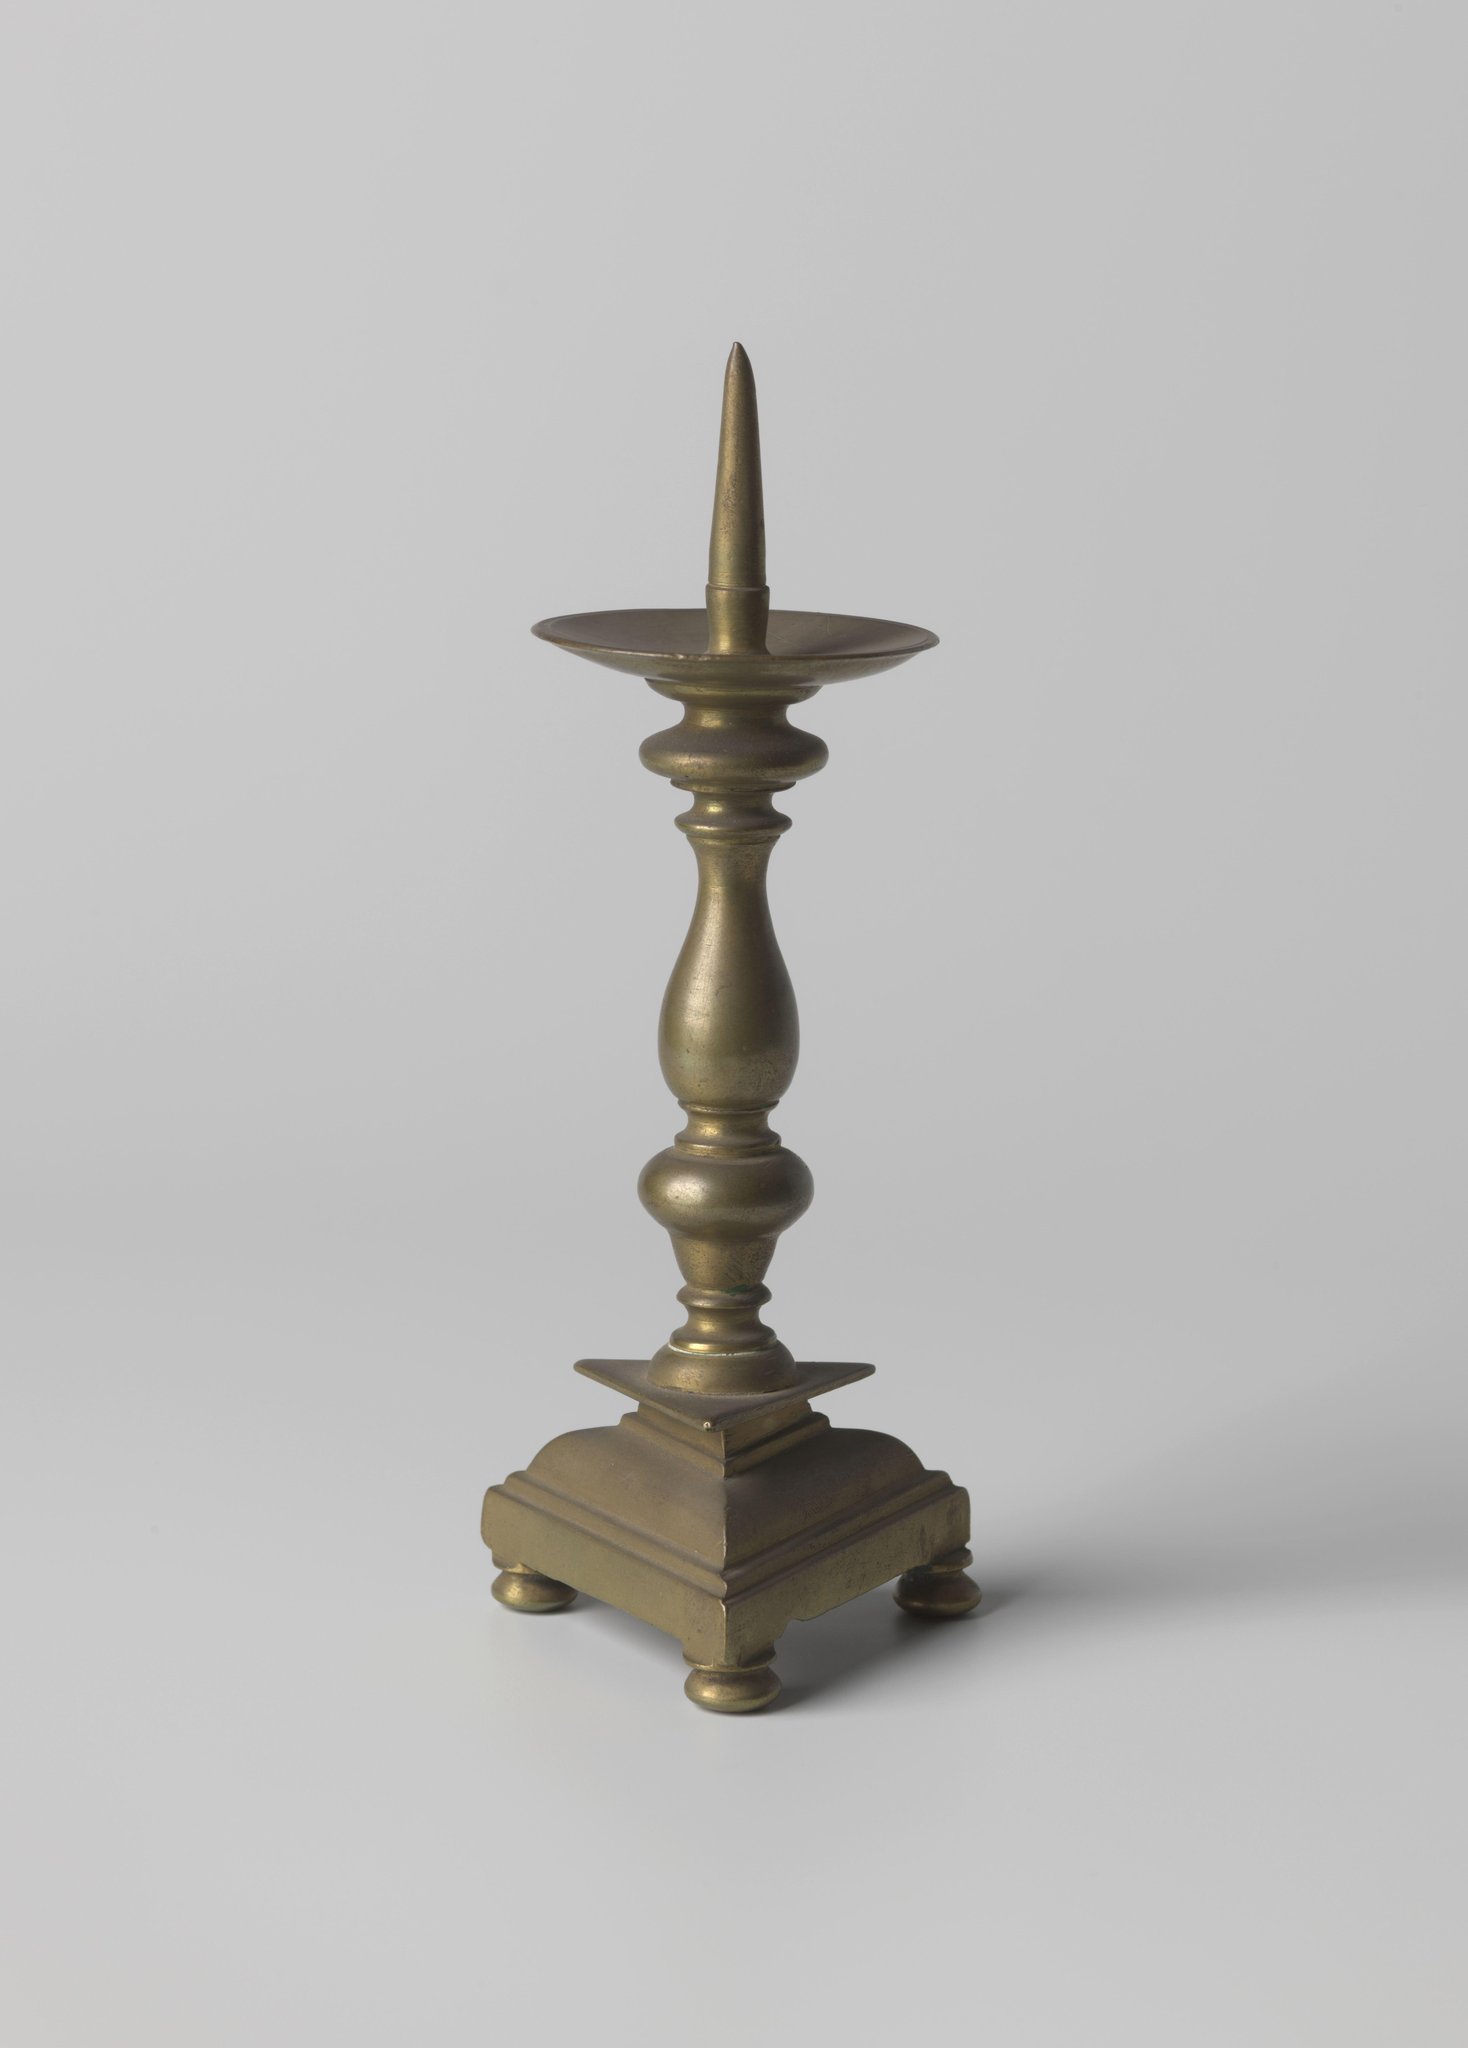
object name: candlestick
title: Kandelaar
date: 1400-1950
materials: brass, copper